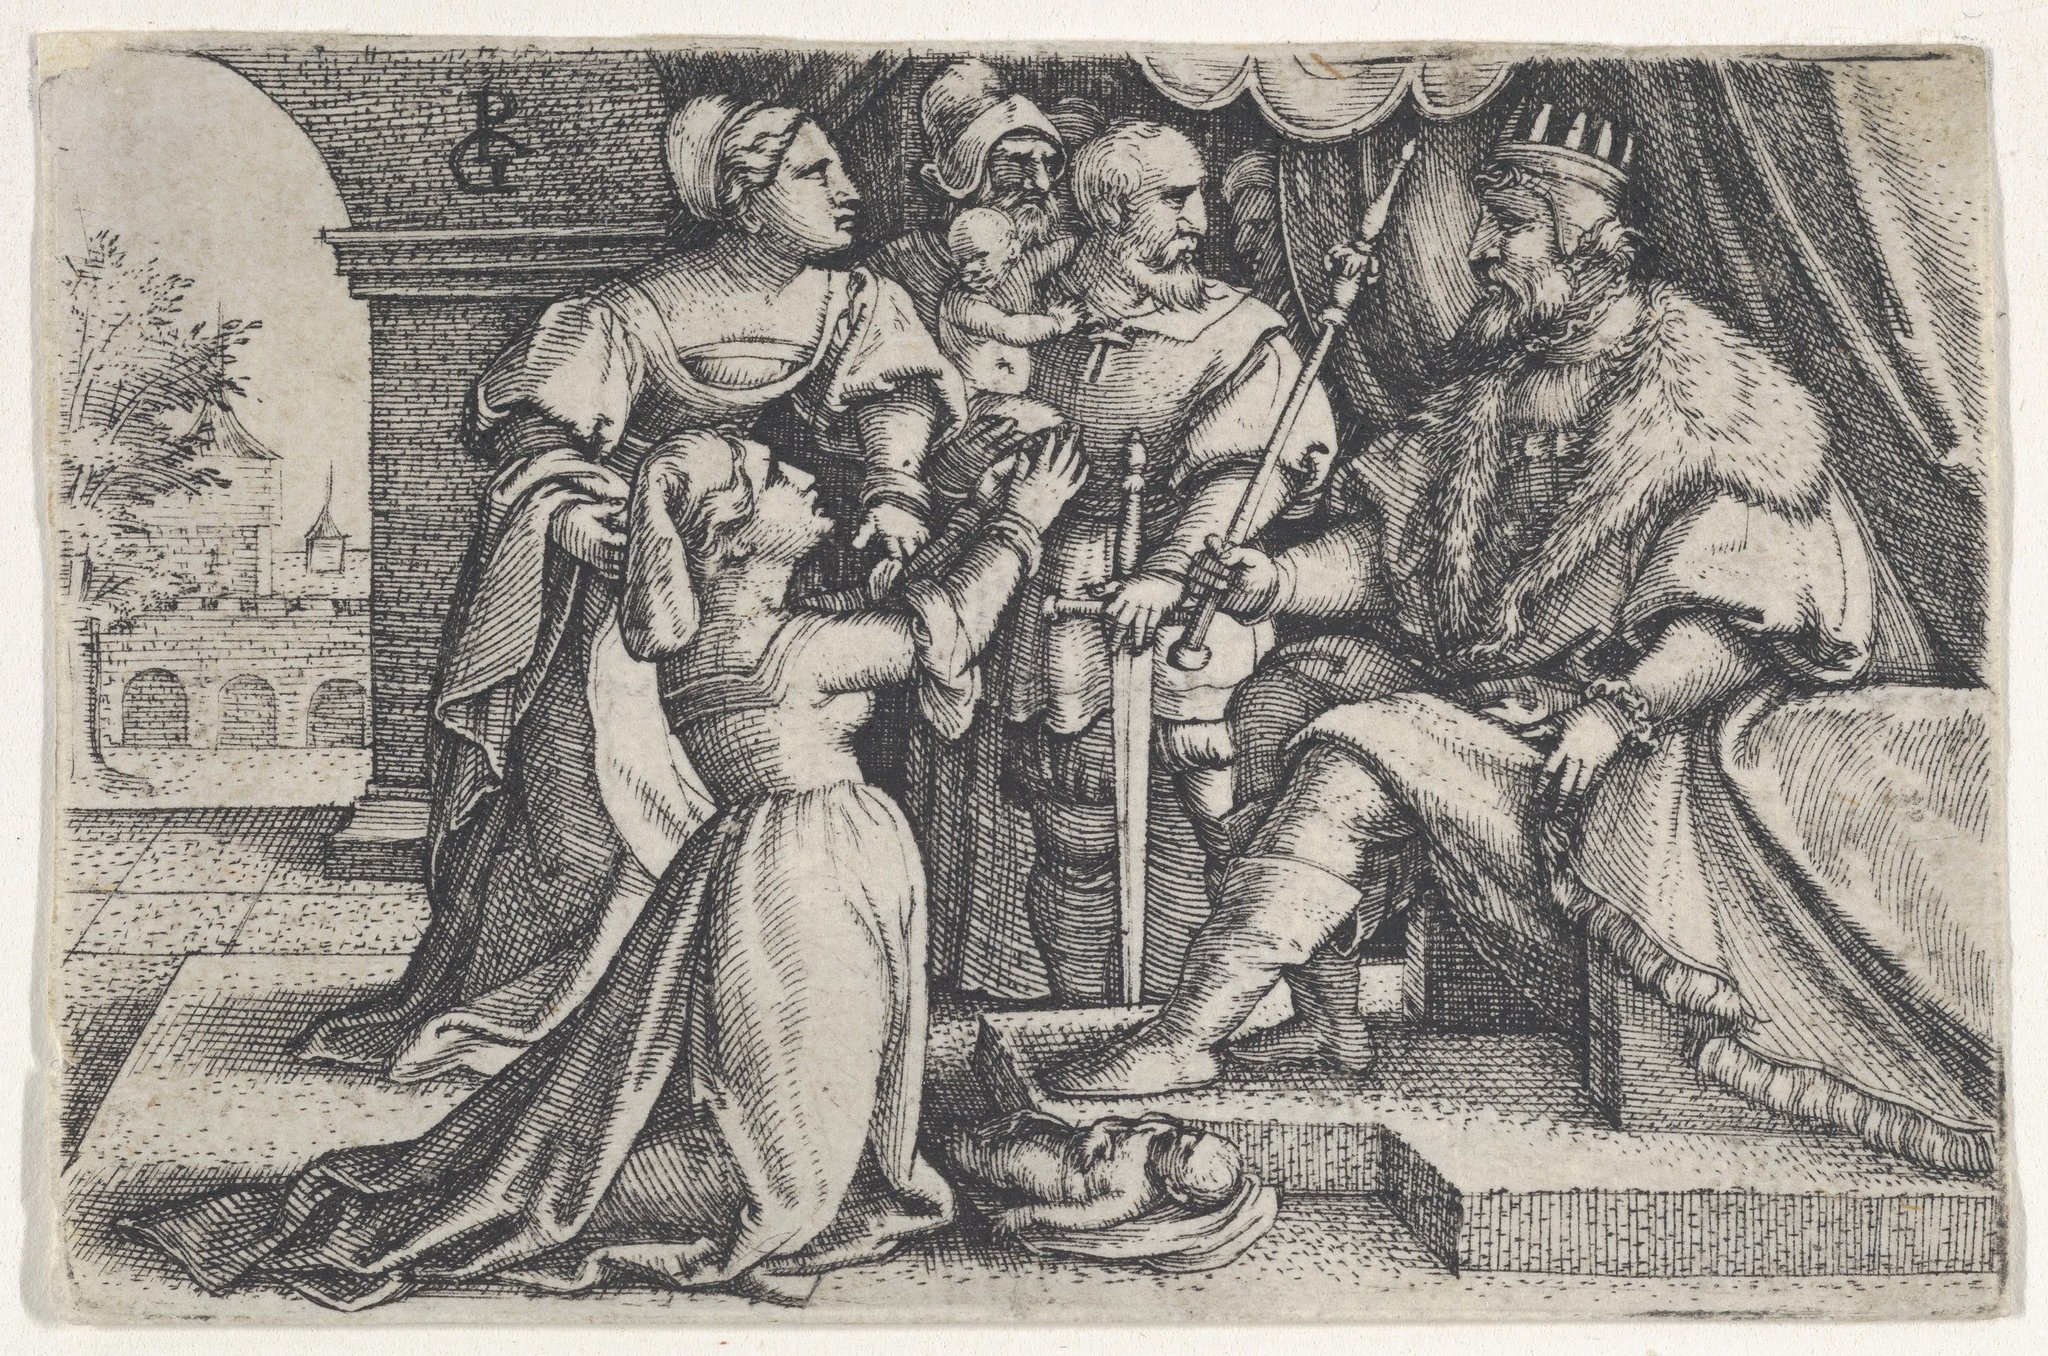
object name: print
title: The Judgment of Solomon, from "Scenes from the Old Testament"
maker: georg pencz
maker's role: artist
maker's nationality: german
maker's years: 1500-1550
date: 1526-1536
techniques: engraving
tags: kings,infants,men,women